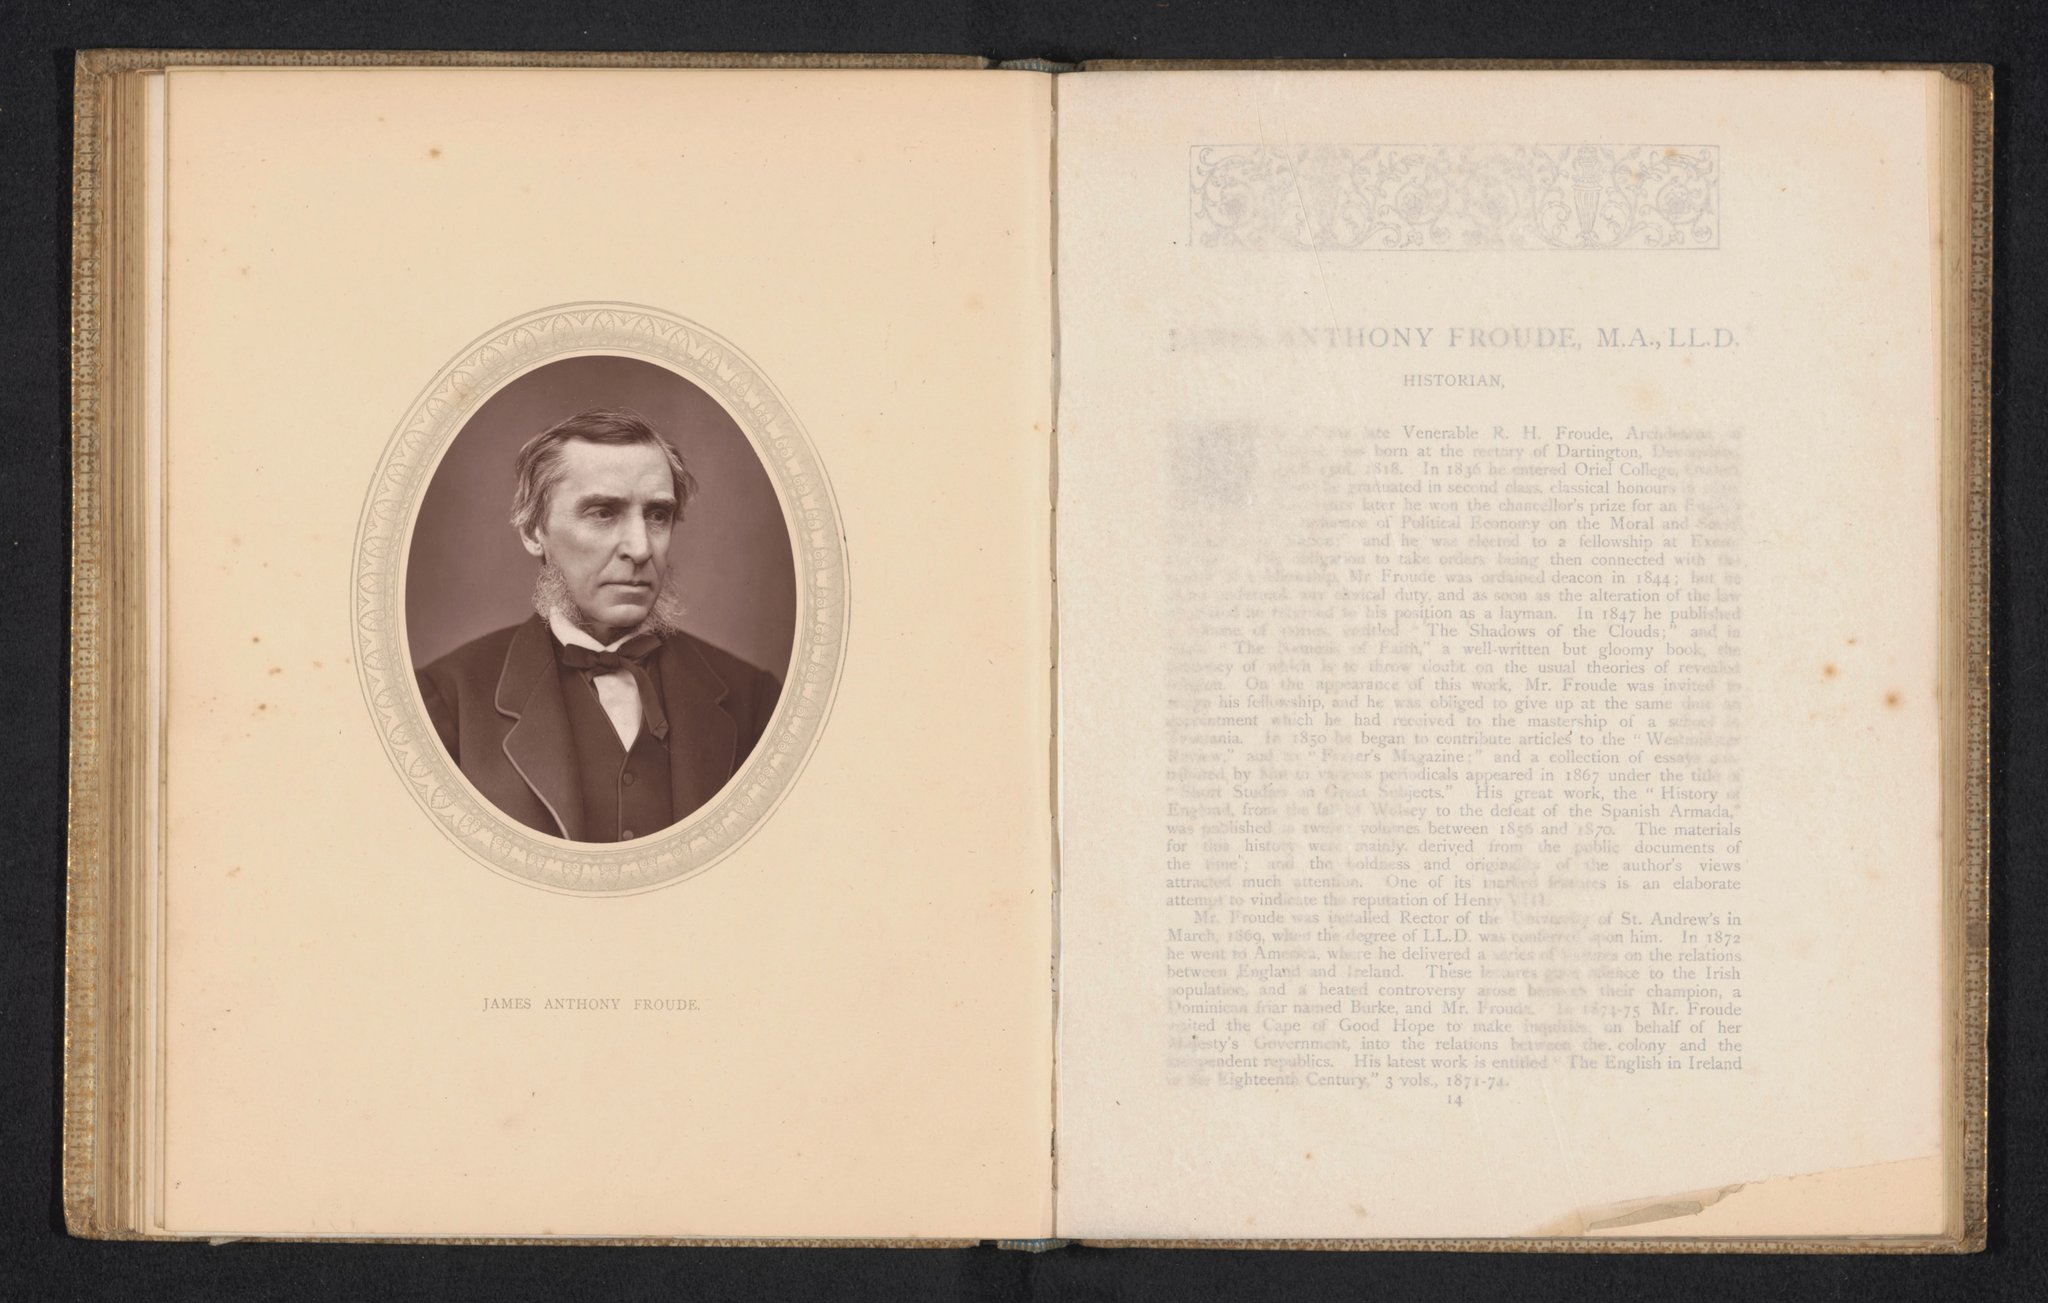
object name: photomechanical print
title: James Anthony Froude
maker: Anonymous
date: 1871-1876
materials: paper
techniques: woodburytype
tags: historical persons (portraits and scenes from the life) (+ (full) bust portrait), writer, poet, author